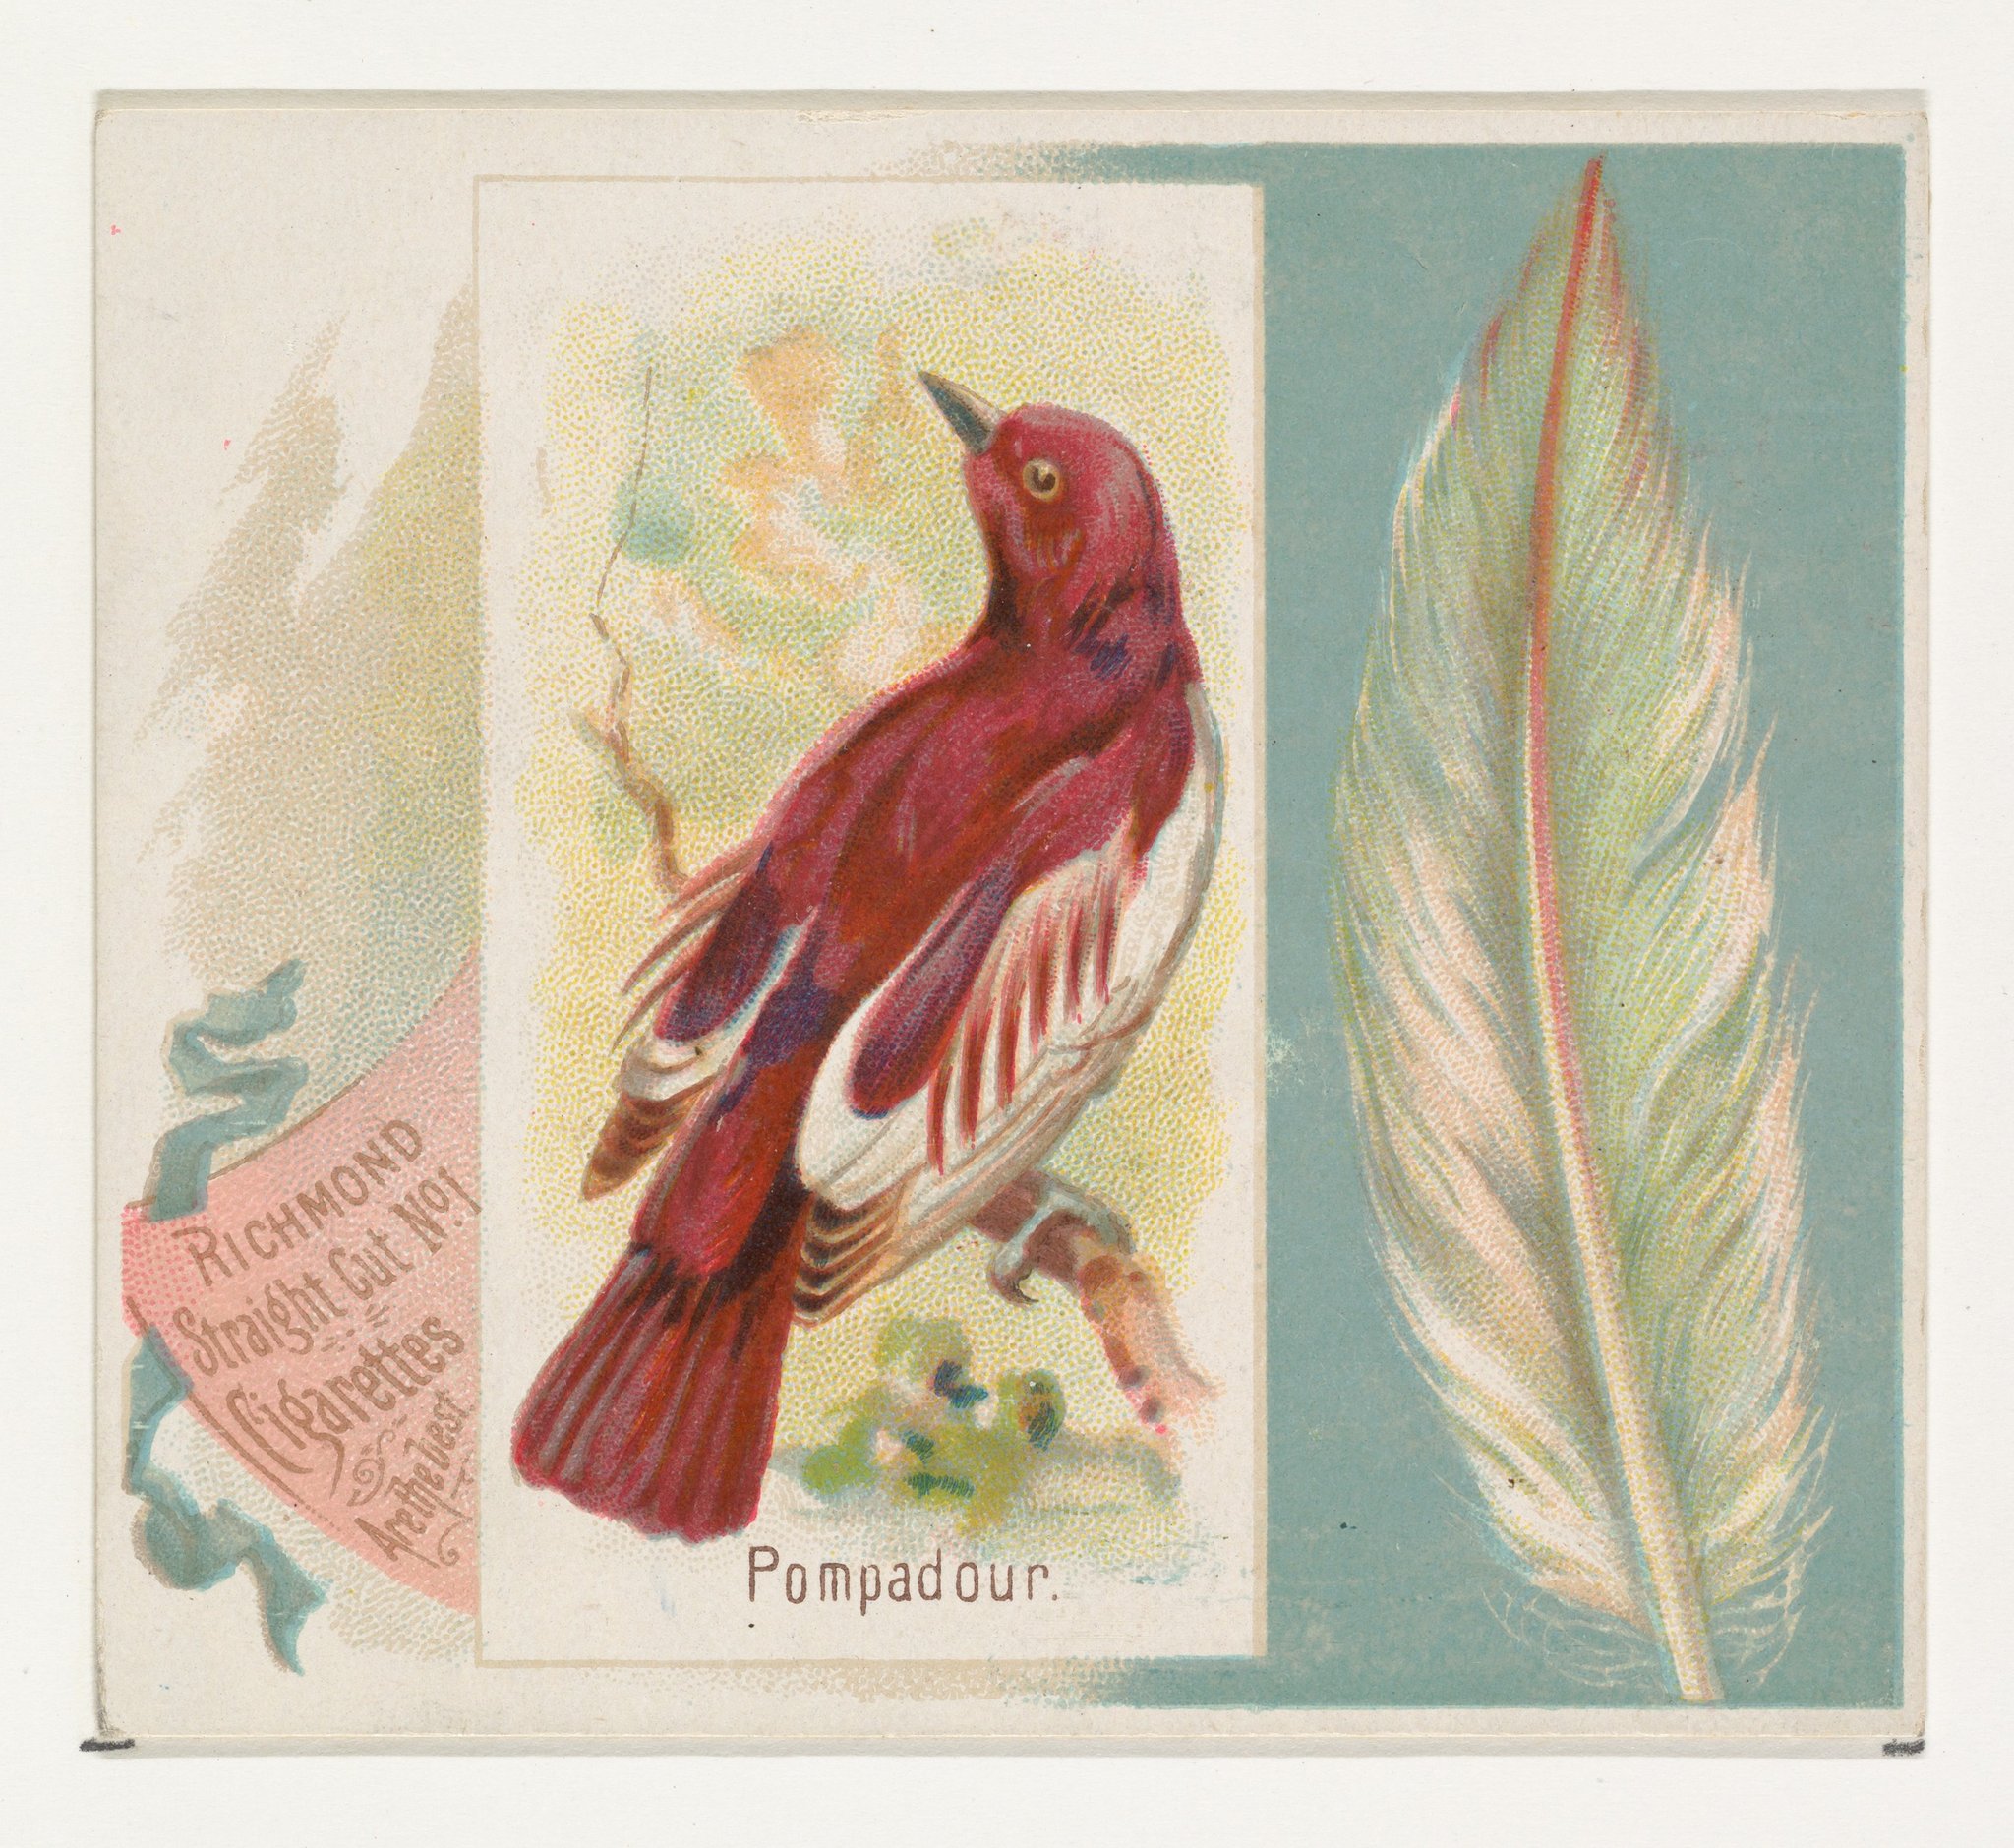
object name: print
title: Pompadour, from the Song Birds of the World series (N42) for Allen & Ginter Cigarettes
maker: allen & ginter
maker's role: publisher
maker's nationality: american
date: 1890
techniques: color lithograph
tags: birds